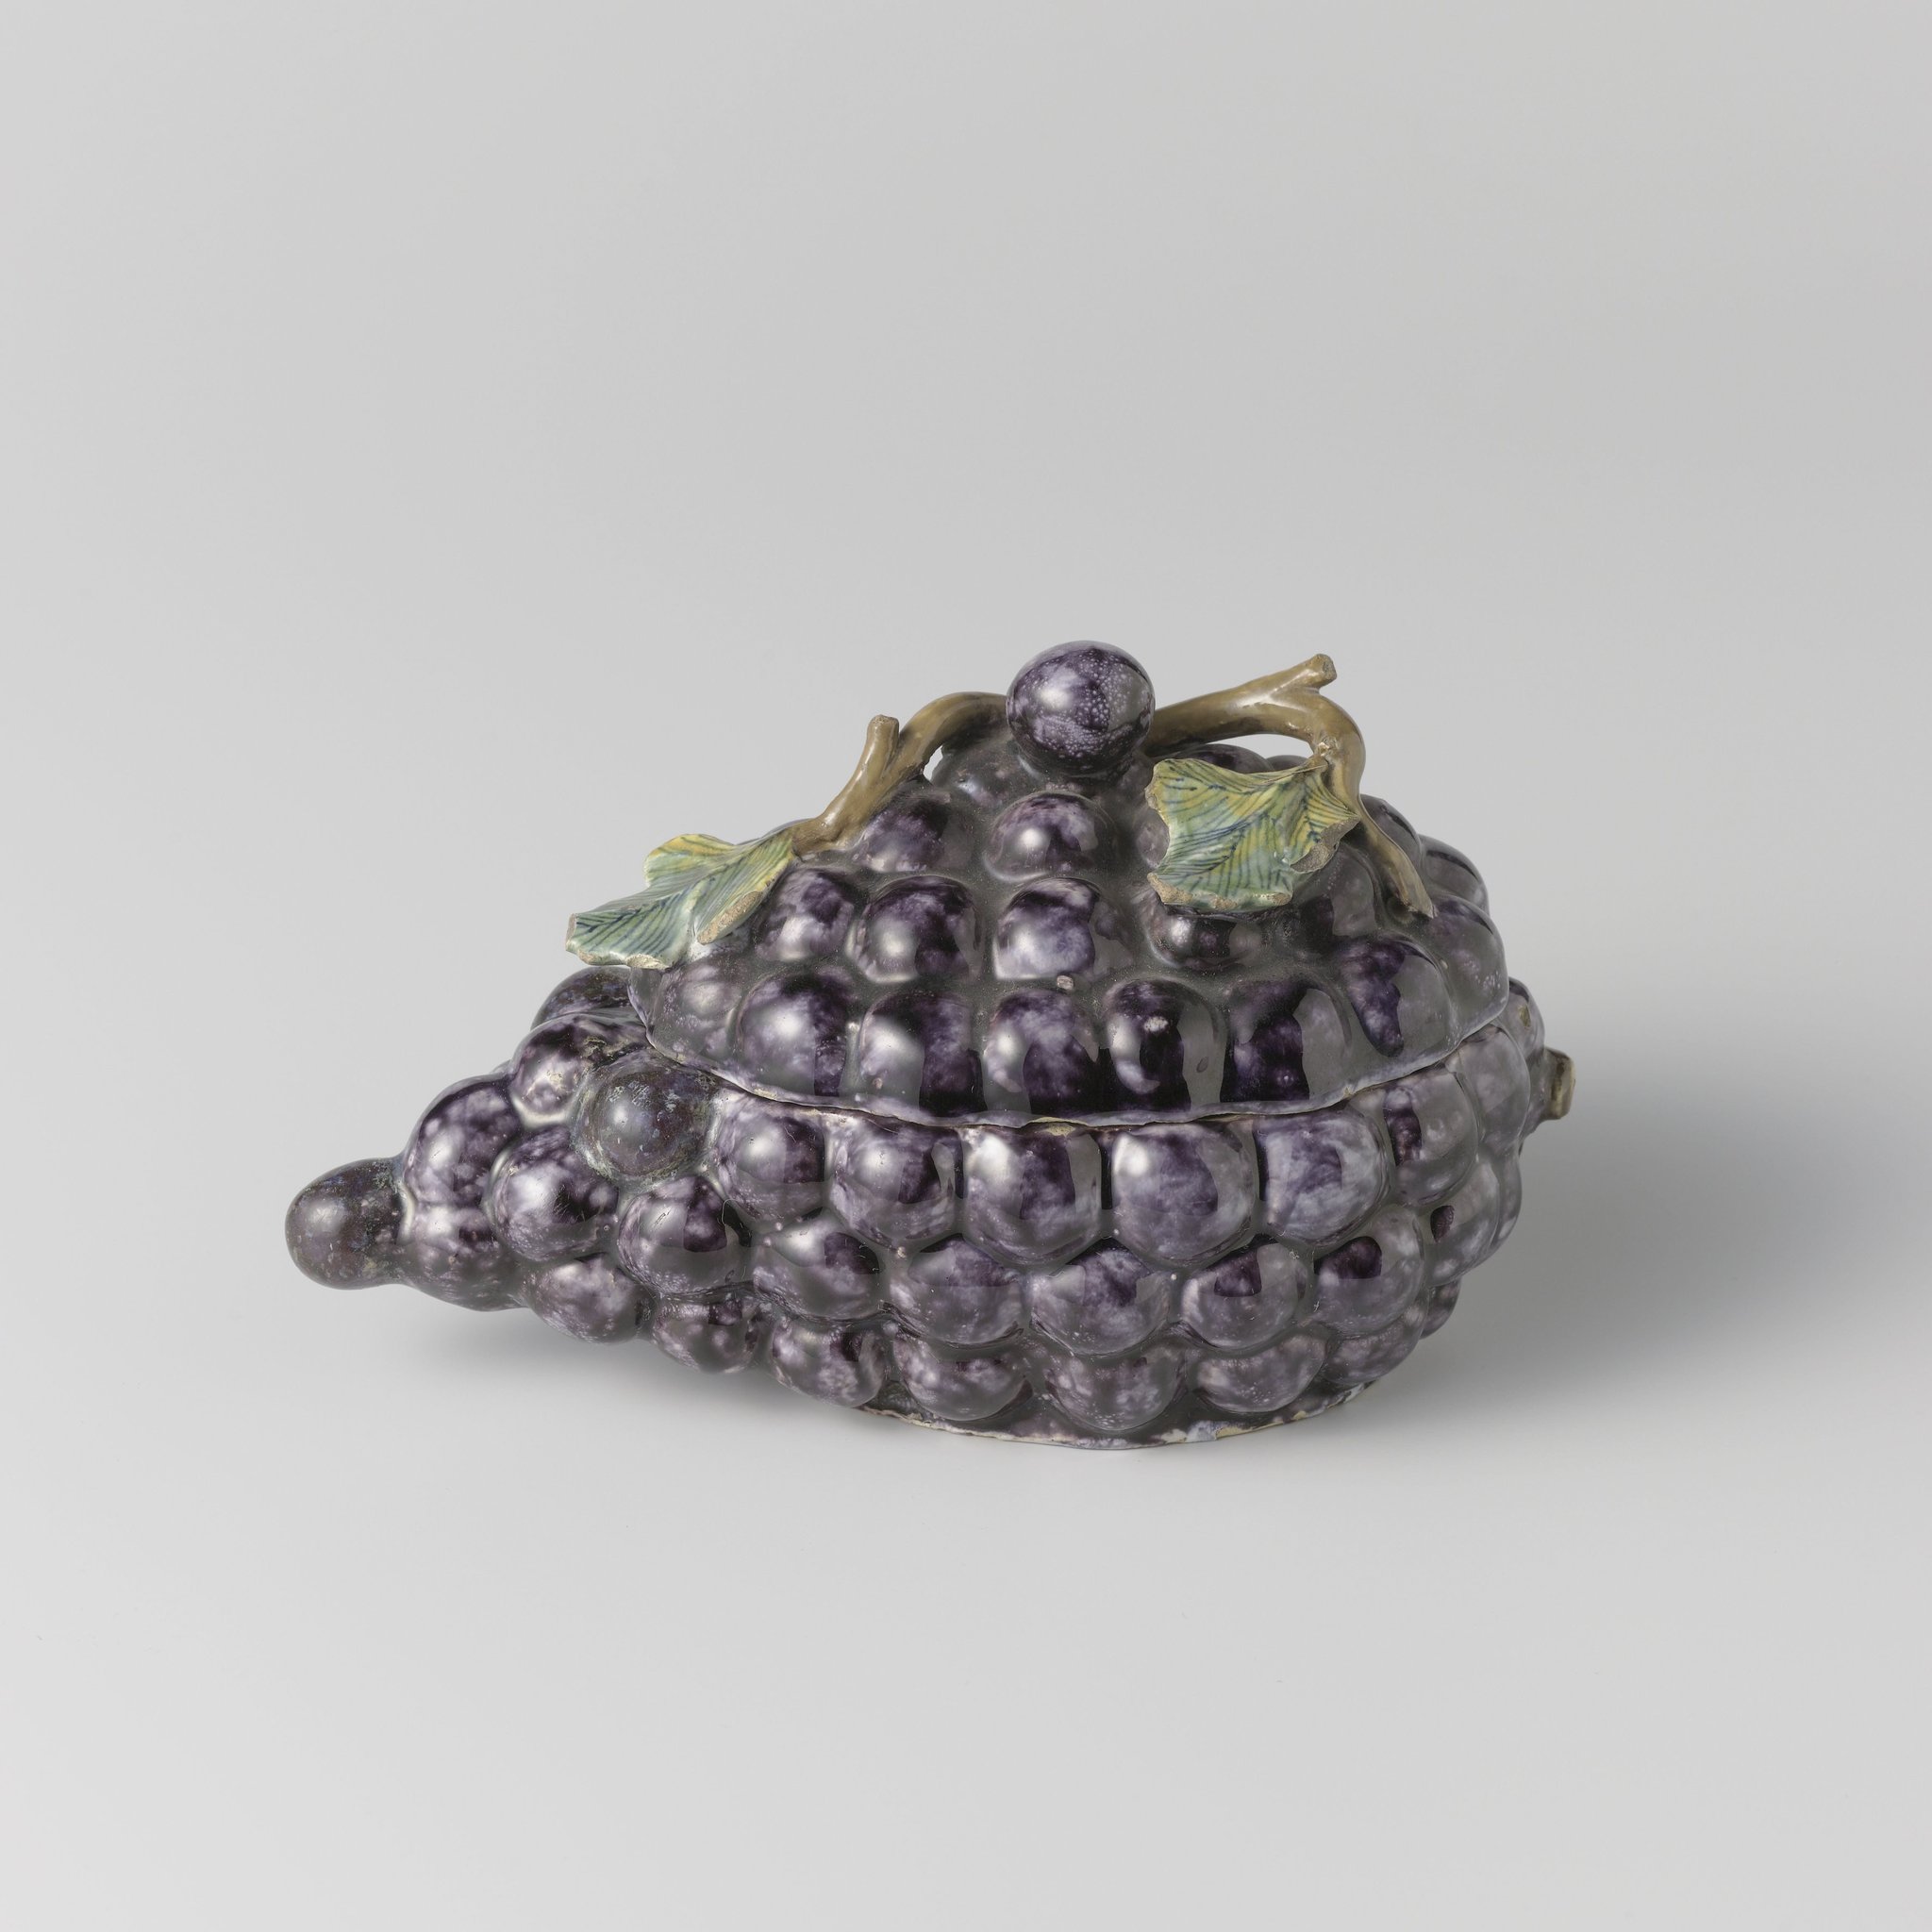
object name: tureen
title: Terrine van veelkleurig beschilderde faience, in de vorm van een druiventros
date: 1750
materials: faience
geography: delft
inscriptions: mark: ‘figuratief teken bijltje met V’, mark: ‘figuratief teken bloem/ 3/ 8’, mark: ‘figuratief teken bijltje met V’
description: Terrine in de vorm van een druiventros. Met bijbehorend deksel en onderschotel.